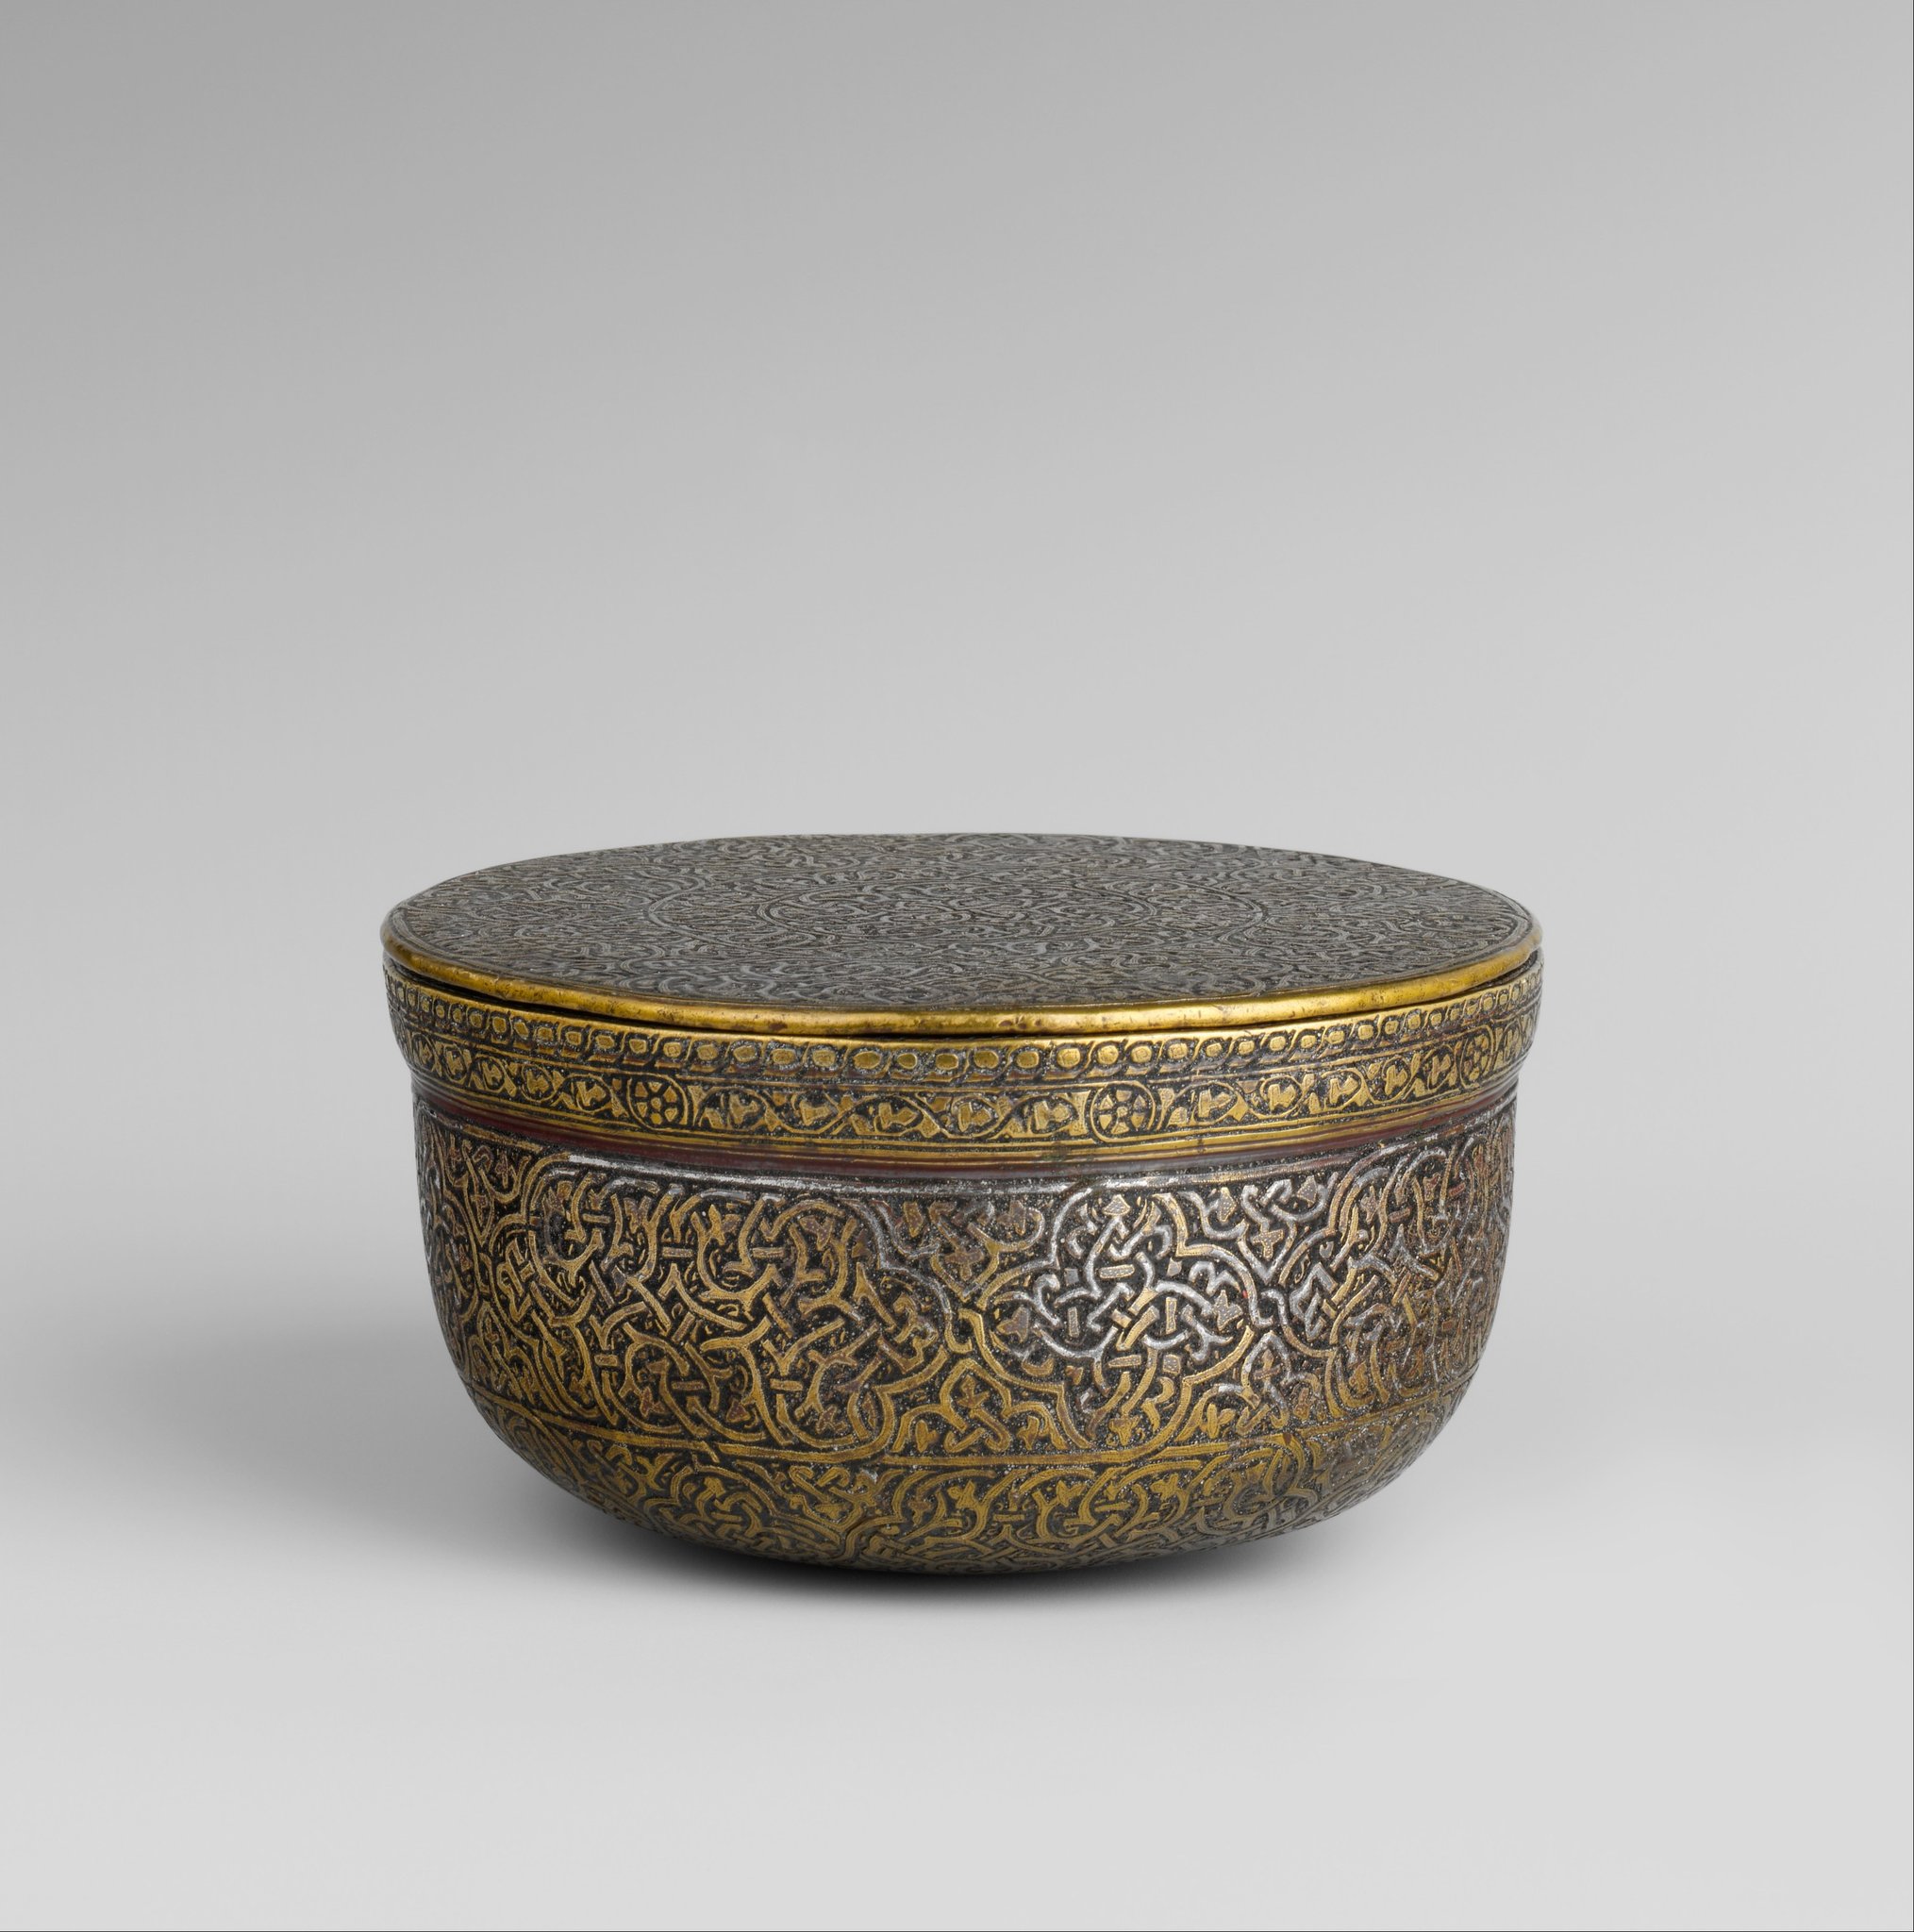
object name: box with cover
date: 1401-1500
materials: brass, niello, silver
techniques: inlay